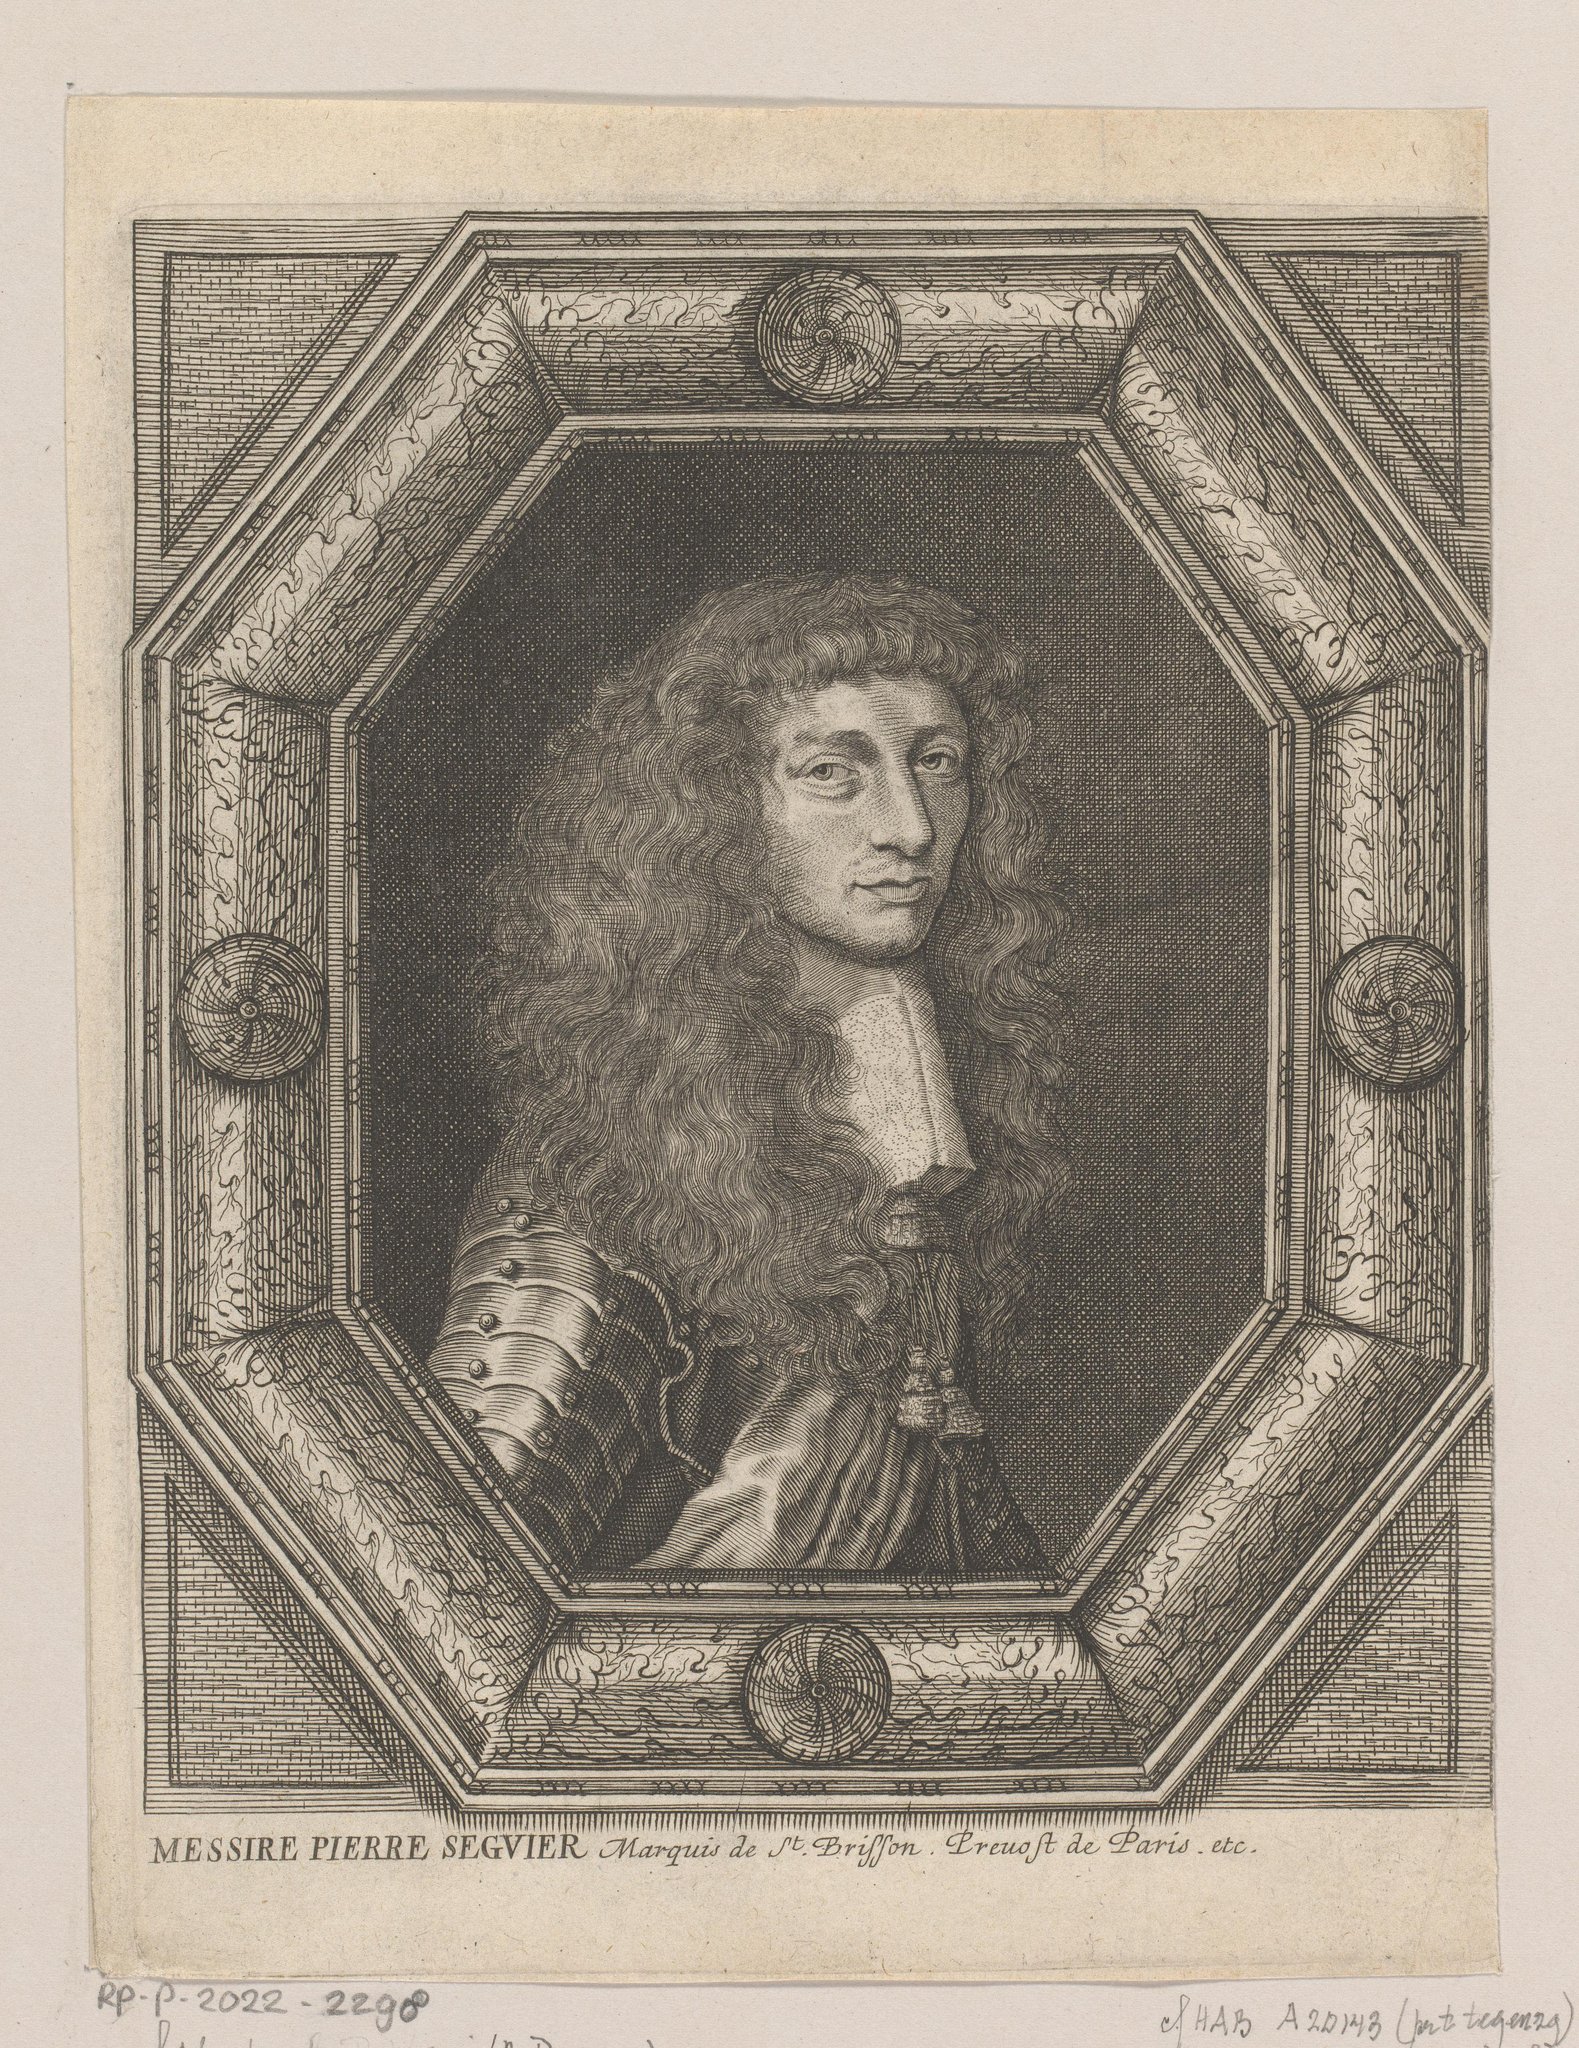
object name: print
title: Portret van Pierre Séguier de Saint-Brisson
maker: Anonymous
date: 1659-1699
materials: paper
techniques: engraving, etching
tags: historical persons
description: Met eenregelig onderschrift in het Frans.